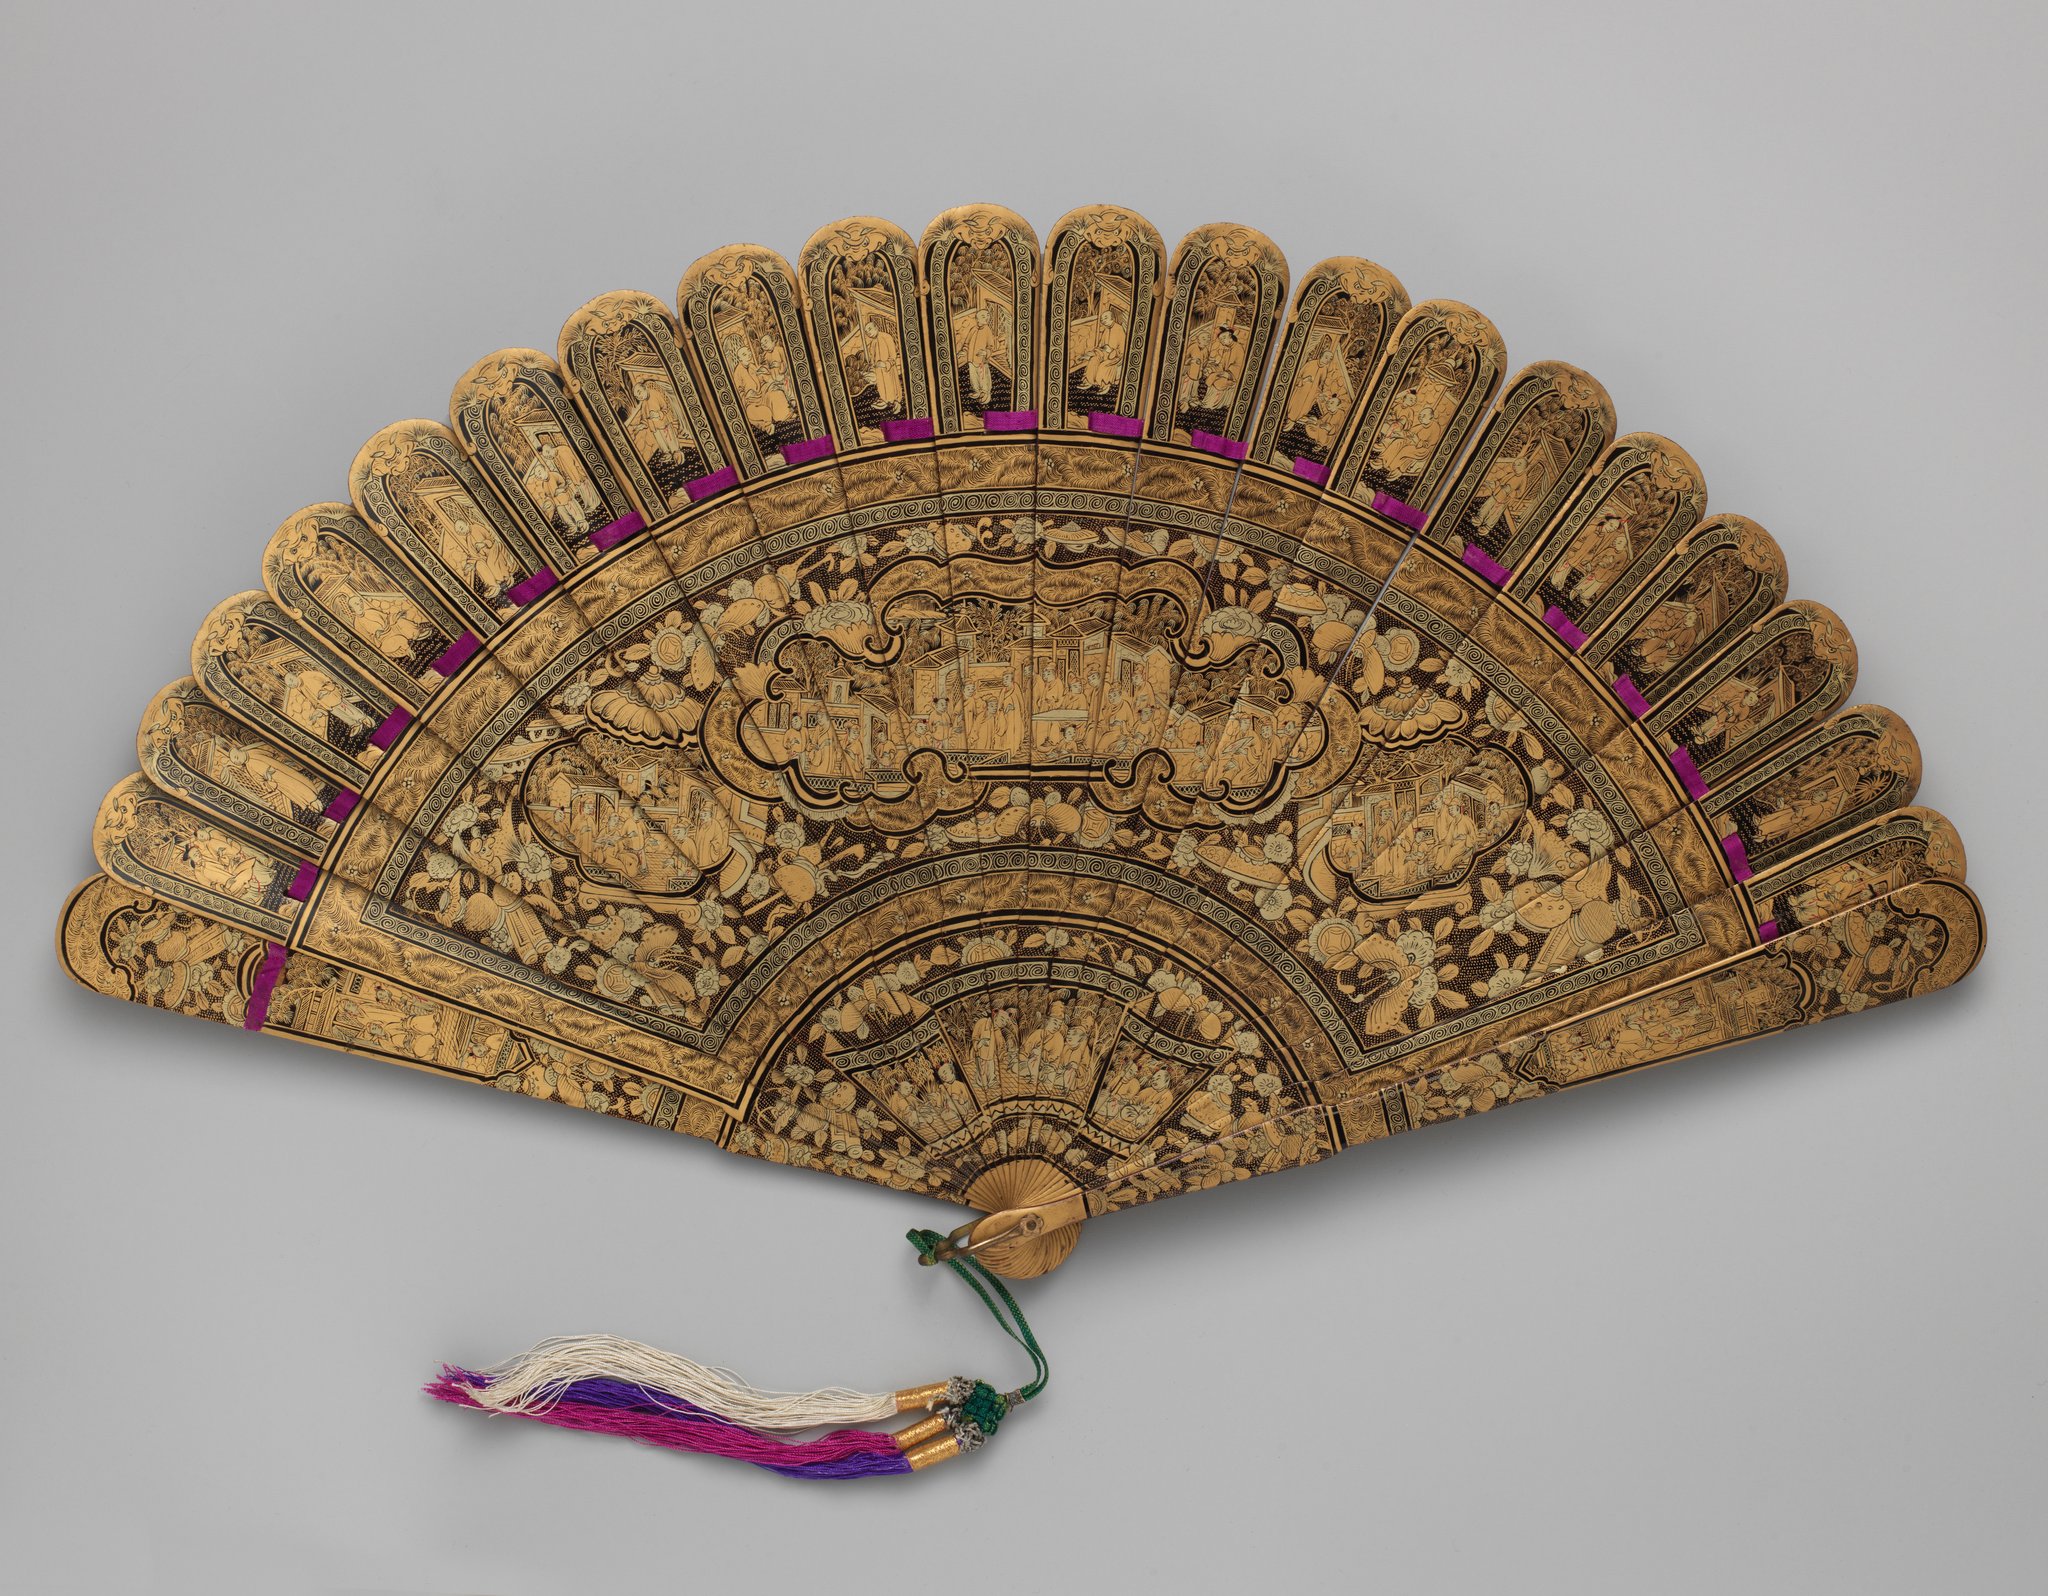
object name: fan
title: Brisé Fan, with Figures in Courtyard Gardens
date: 1801-1900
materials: wood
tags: men